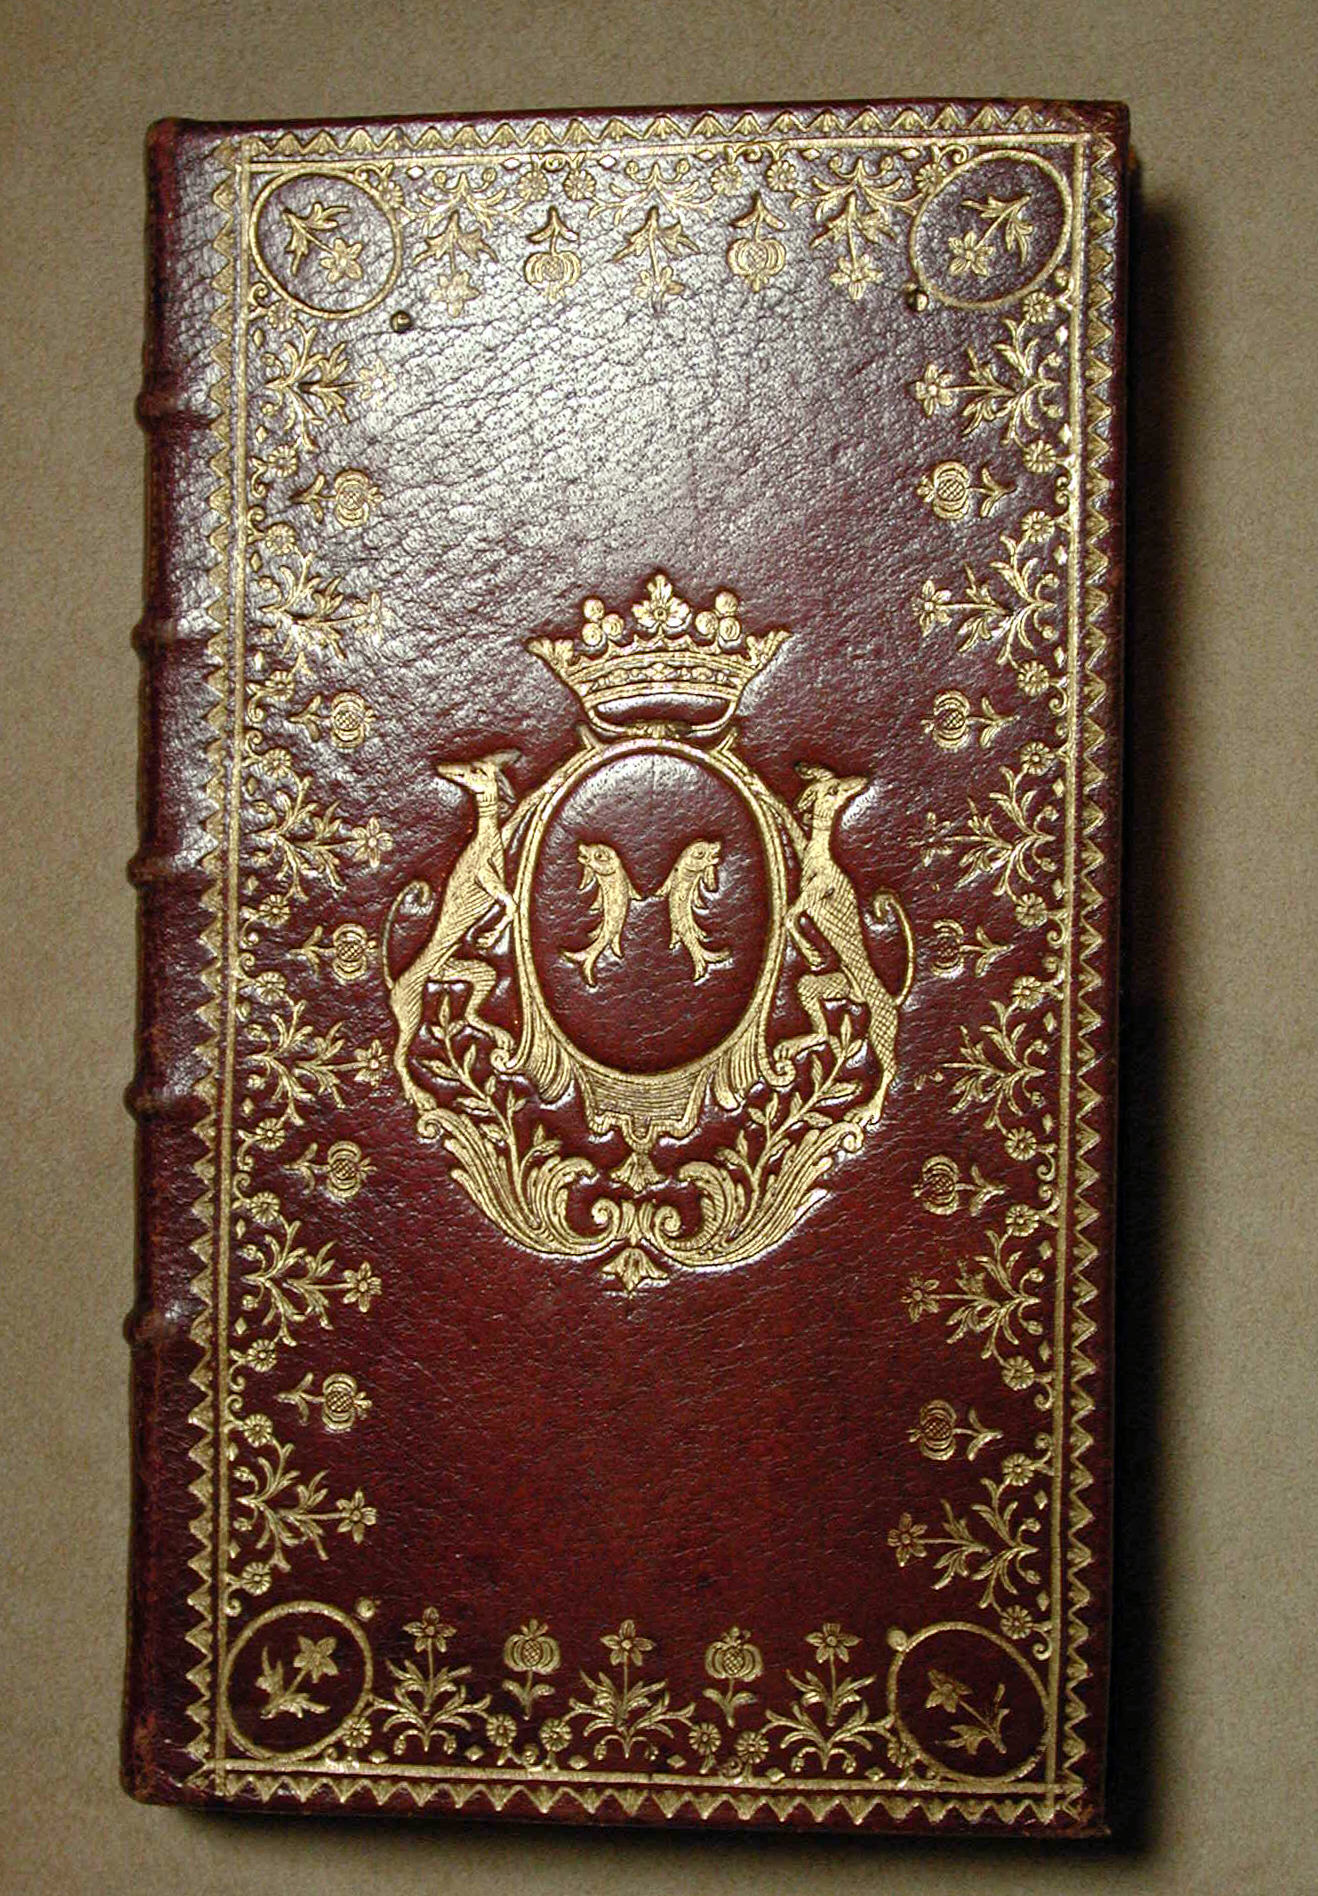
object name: book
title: Les Échappemens à repos comparés aux echappemens à recul; et Examen des dernières observations de Monsieur de La Lande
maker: jean jodin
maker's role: artist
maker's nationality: swiss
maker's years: 1715-1761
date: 1755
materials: leather, paper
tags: coat of arms